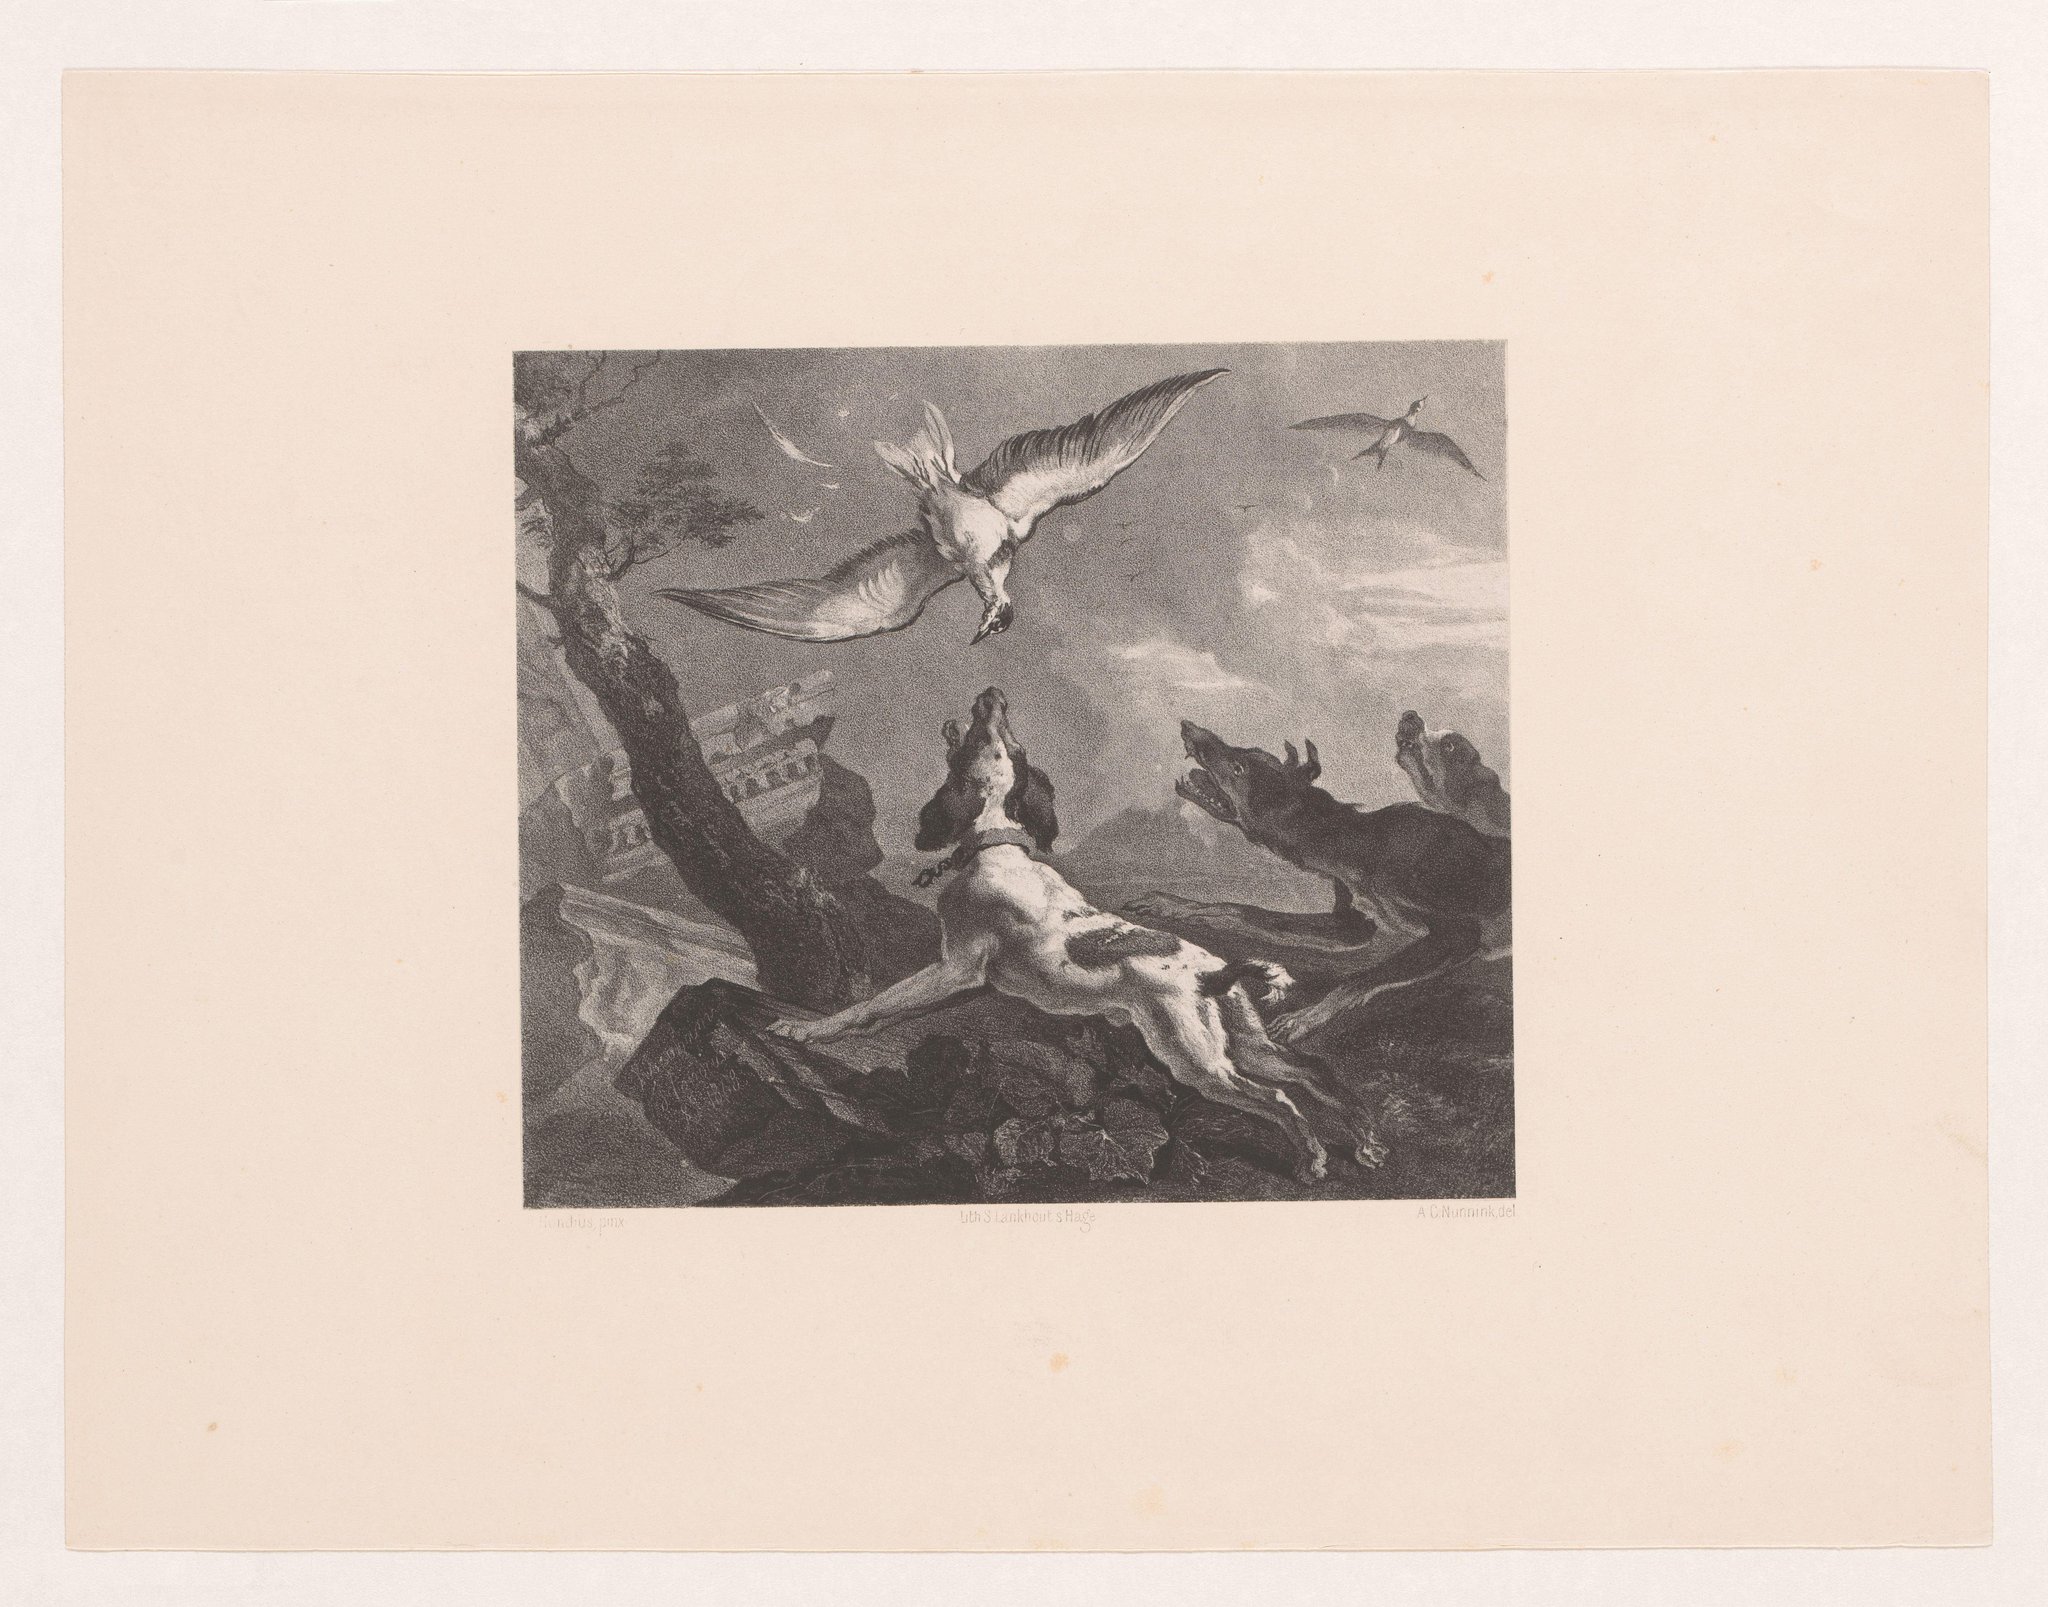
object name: print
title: Honden jagen op vogels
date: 1868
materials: paper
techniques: lithograph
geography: the hague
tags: hunting dogs, bird hunting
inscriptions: collector's mark: Lugt 2228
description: Prent naar schilderij van Abraham Daniëlsz Hondius, gedateerd 1868.